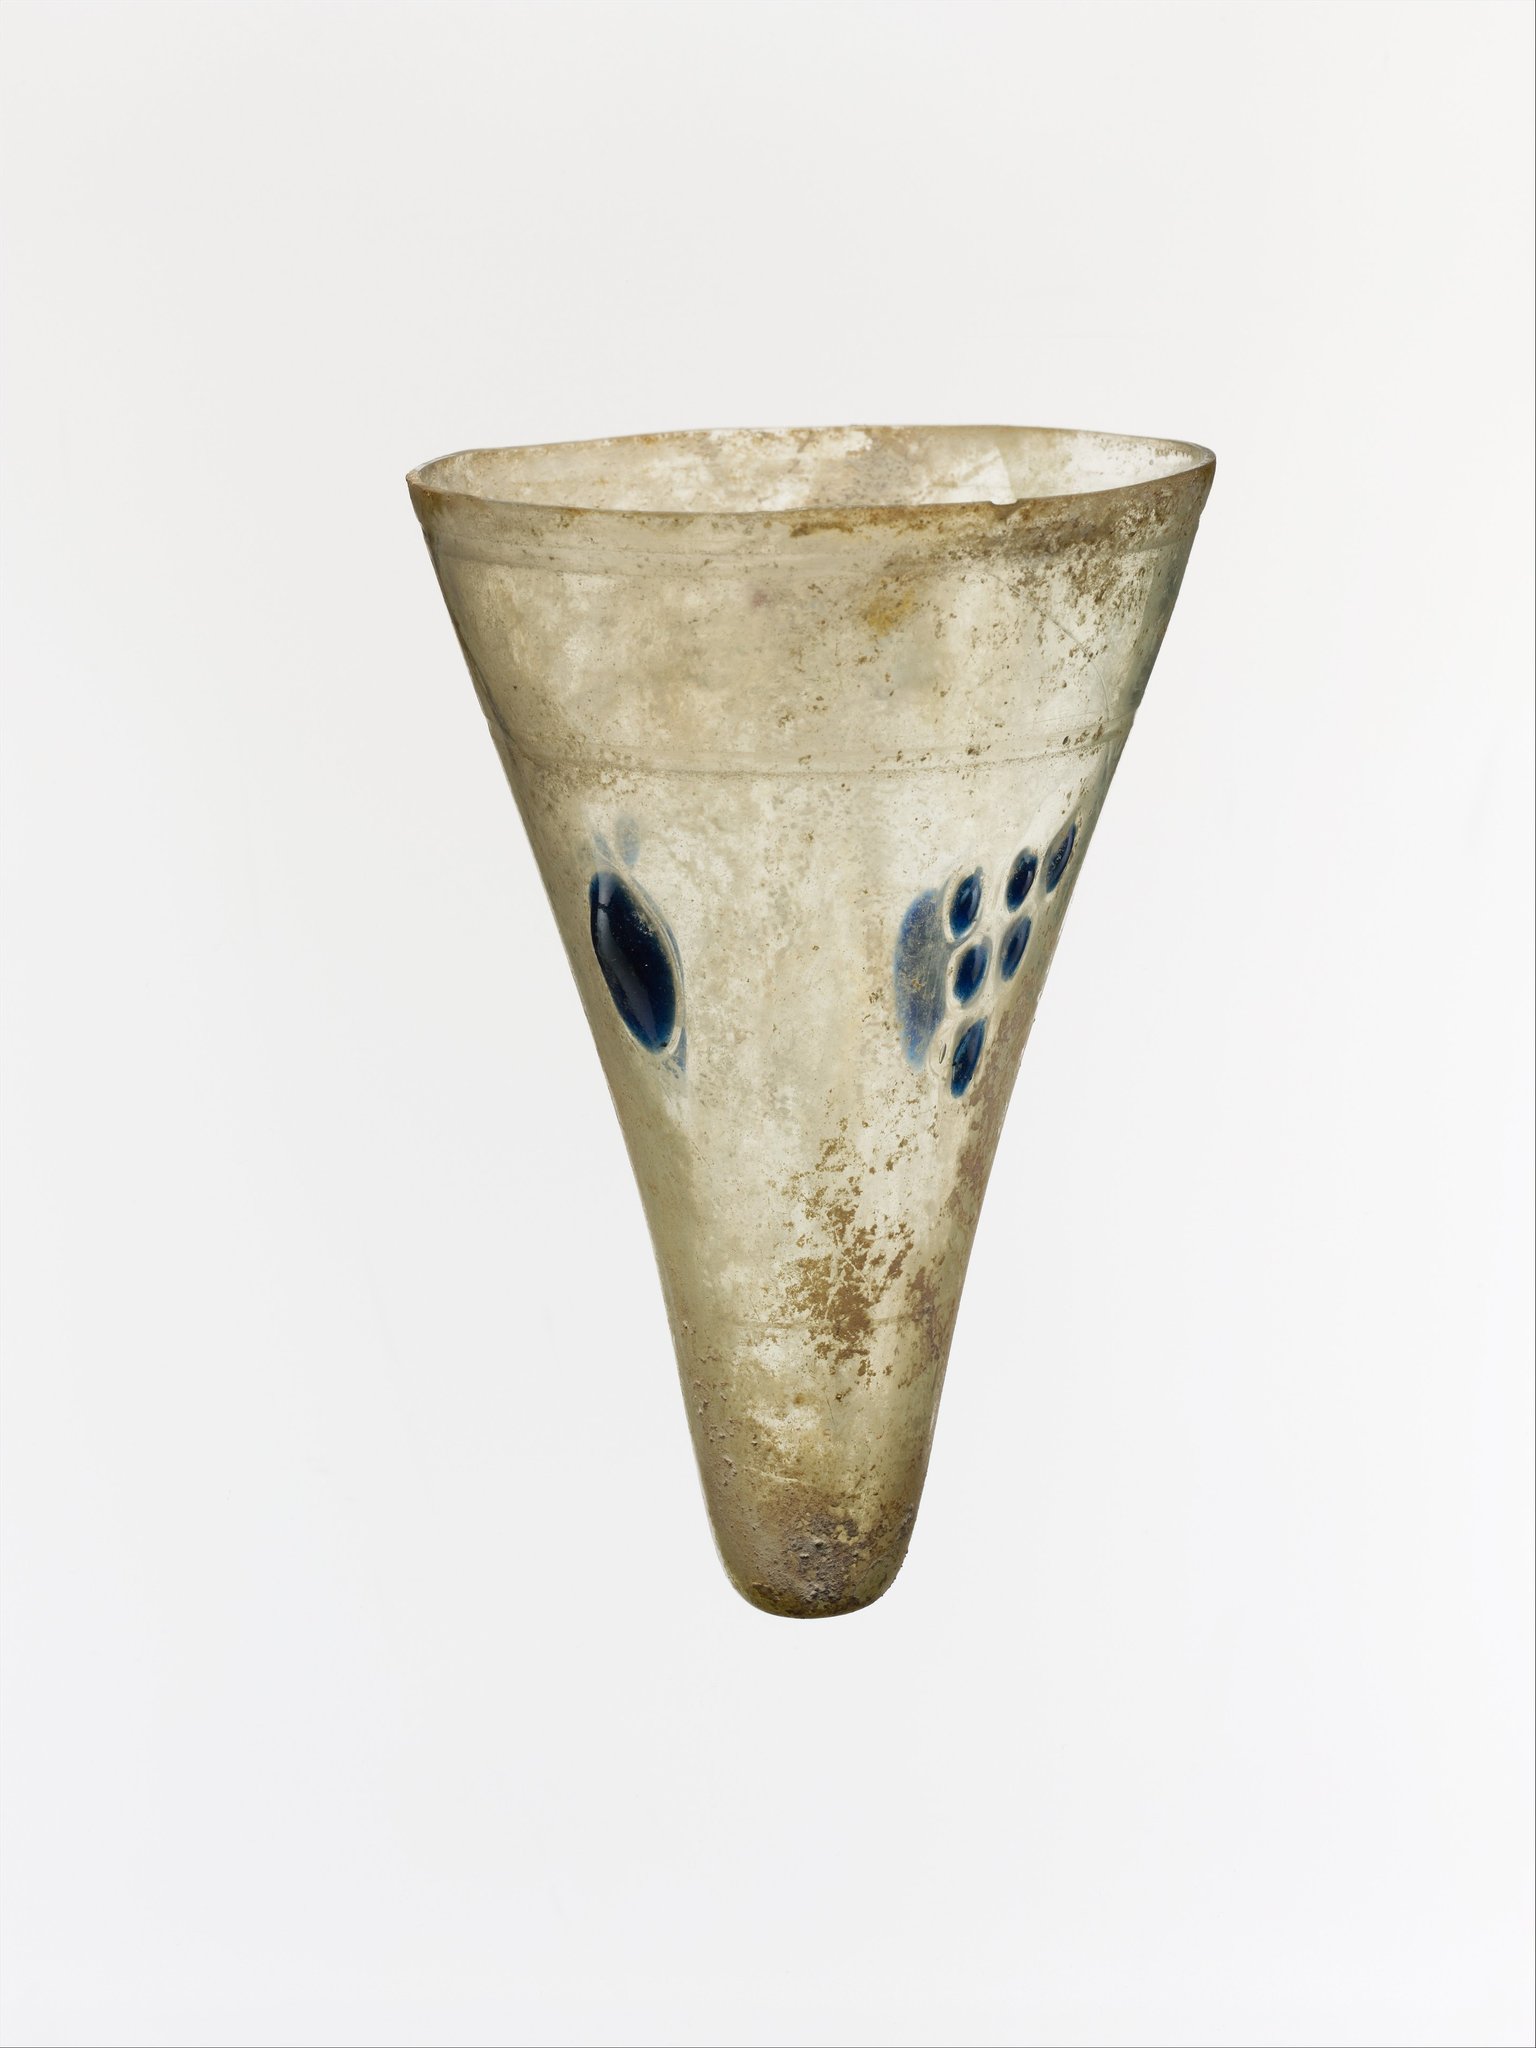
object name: beaker or lamp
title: Glass conical beaker or lamp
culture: roman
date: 301-500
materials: glass